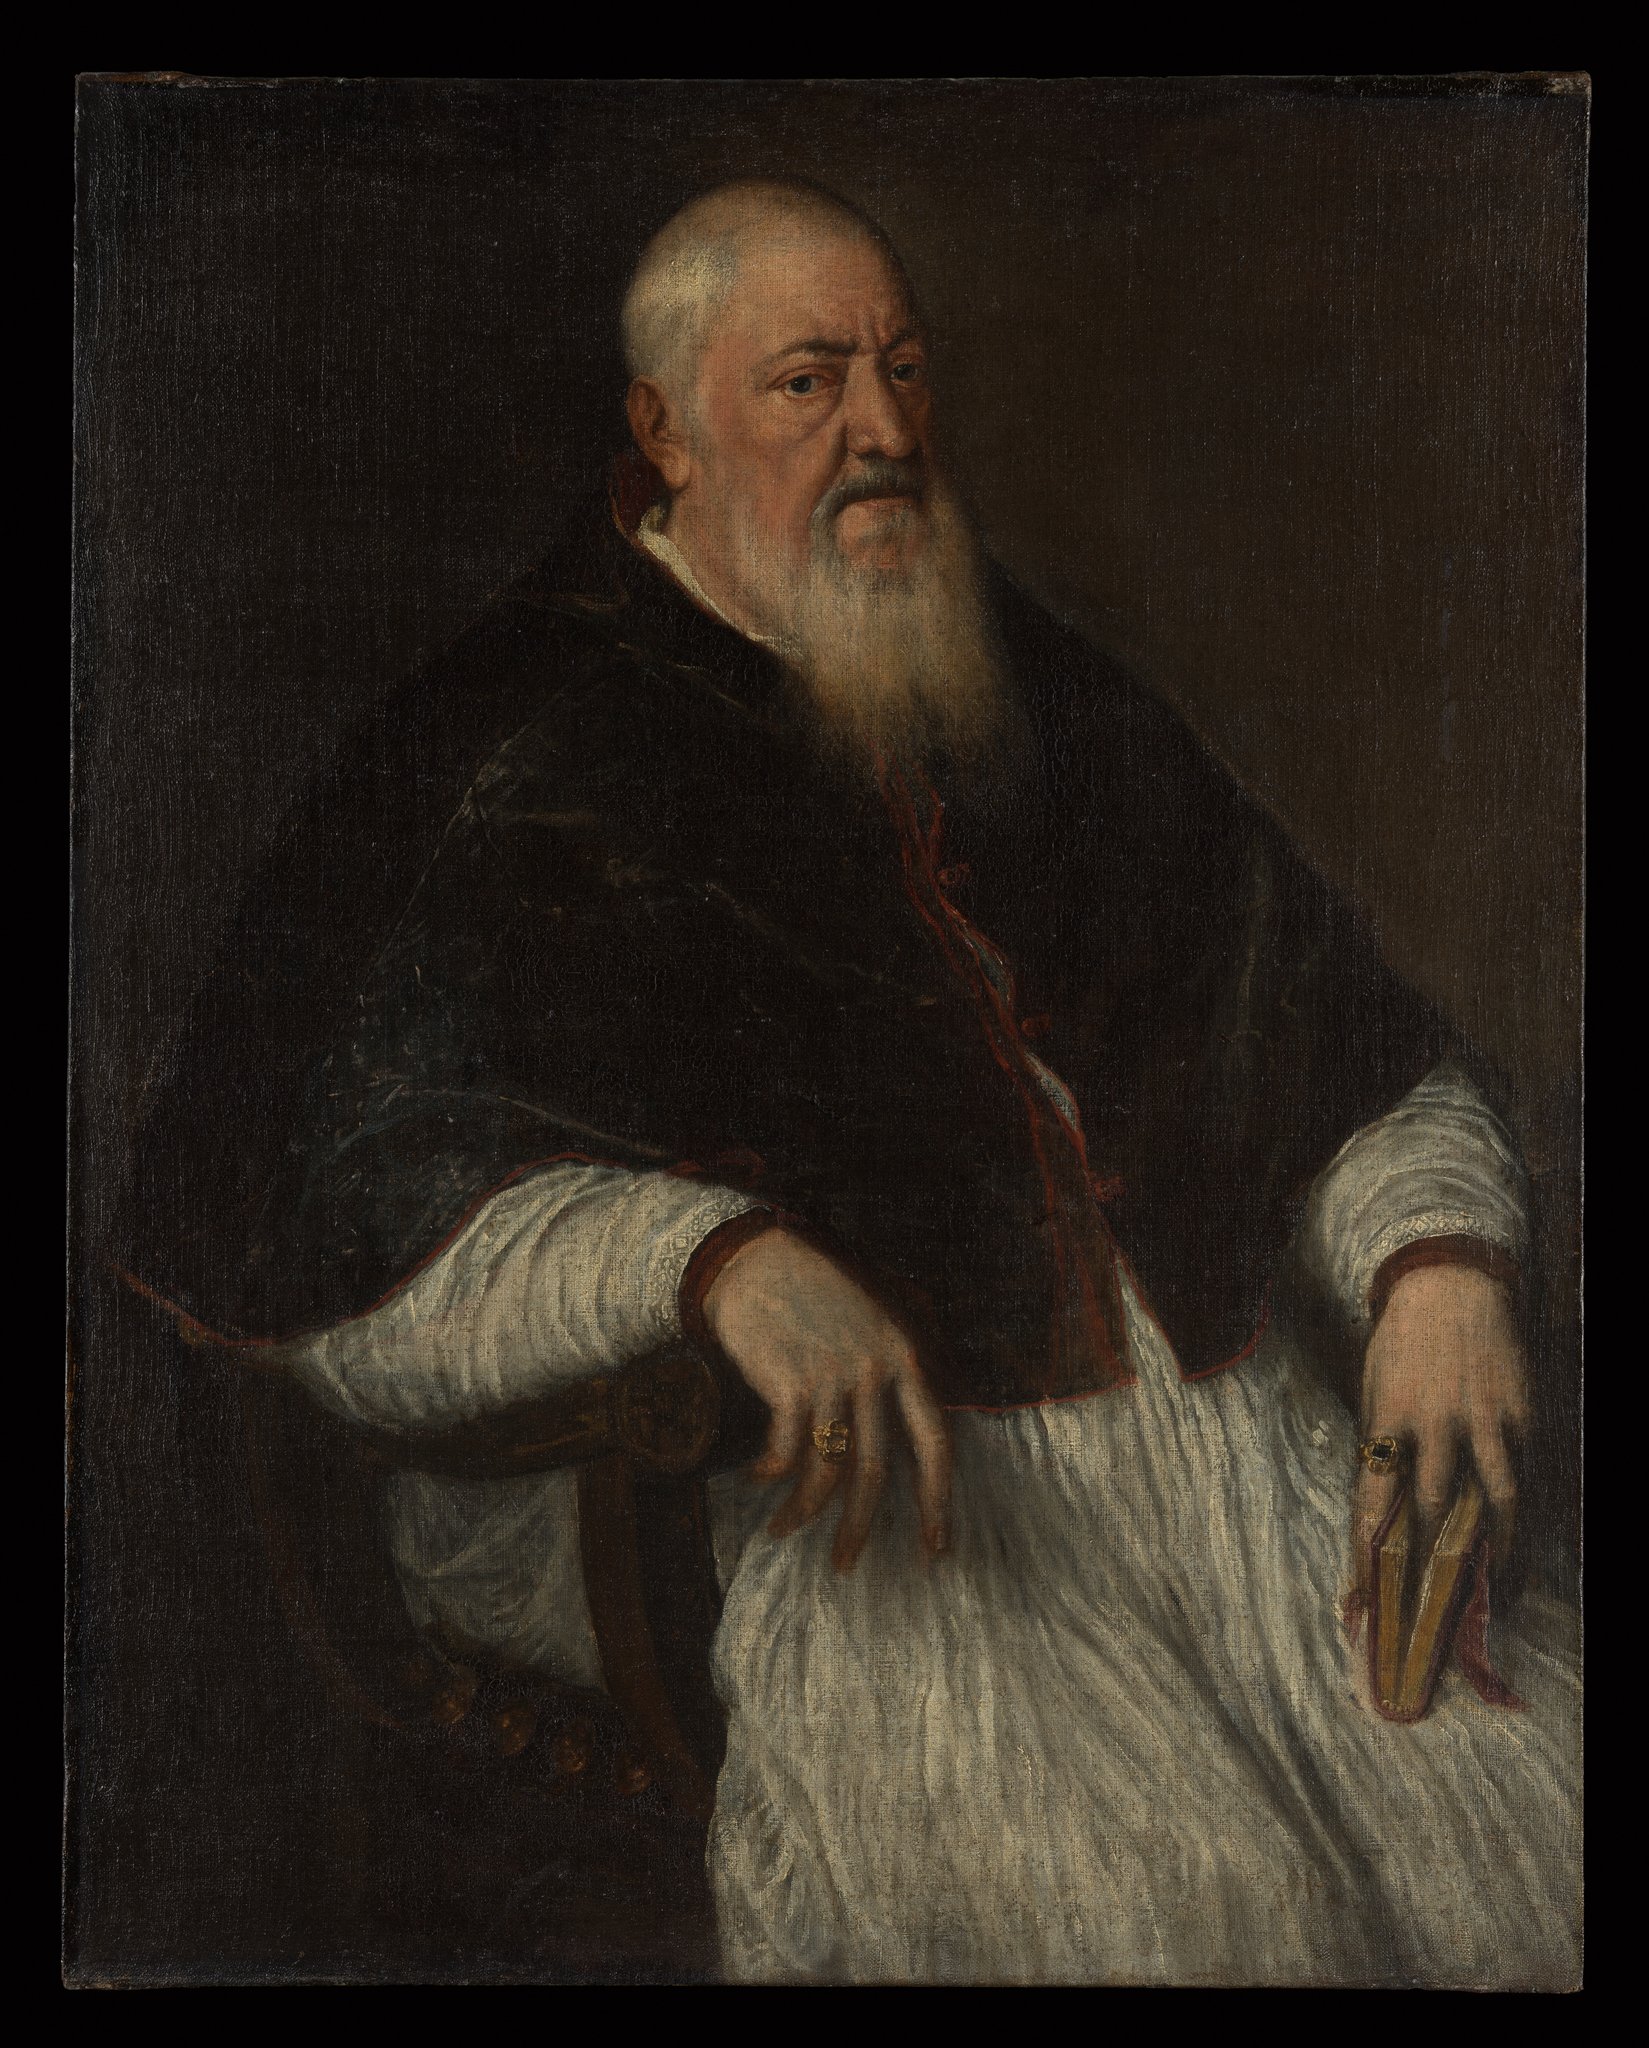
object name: painting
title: Filippo Archinto (born about 1500, died 1558), Archbishop of Milan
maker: titian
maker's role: artist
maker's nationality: italian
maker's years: 1485-1576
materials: canvas, oil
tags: men,portraits